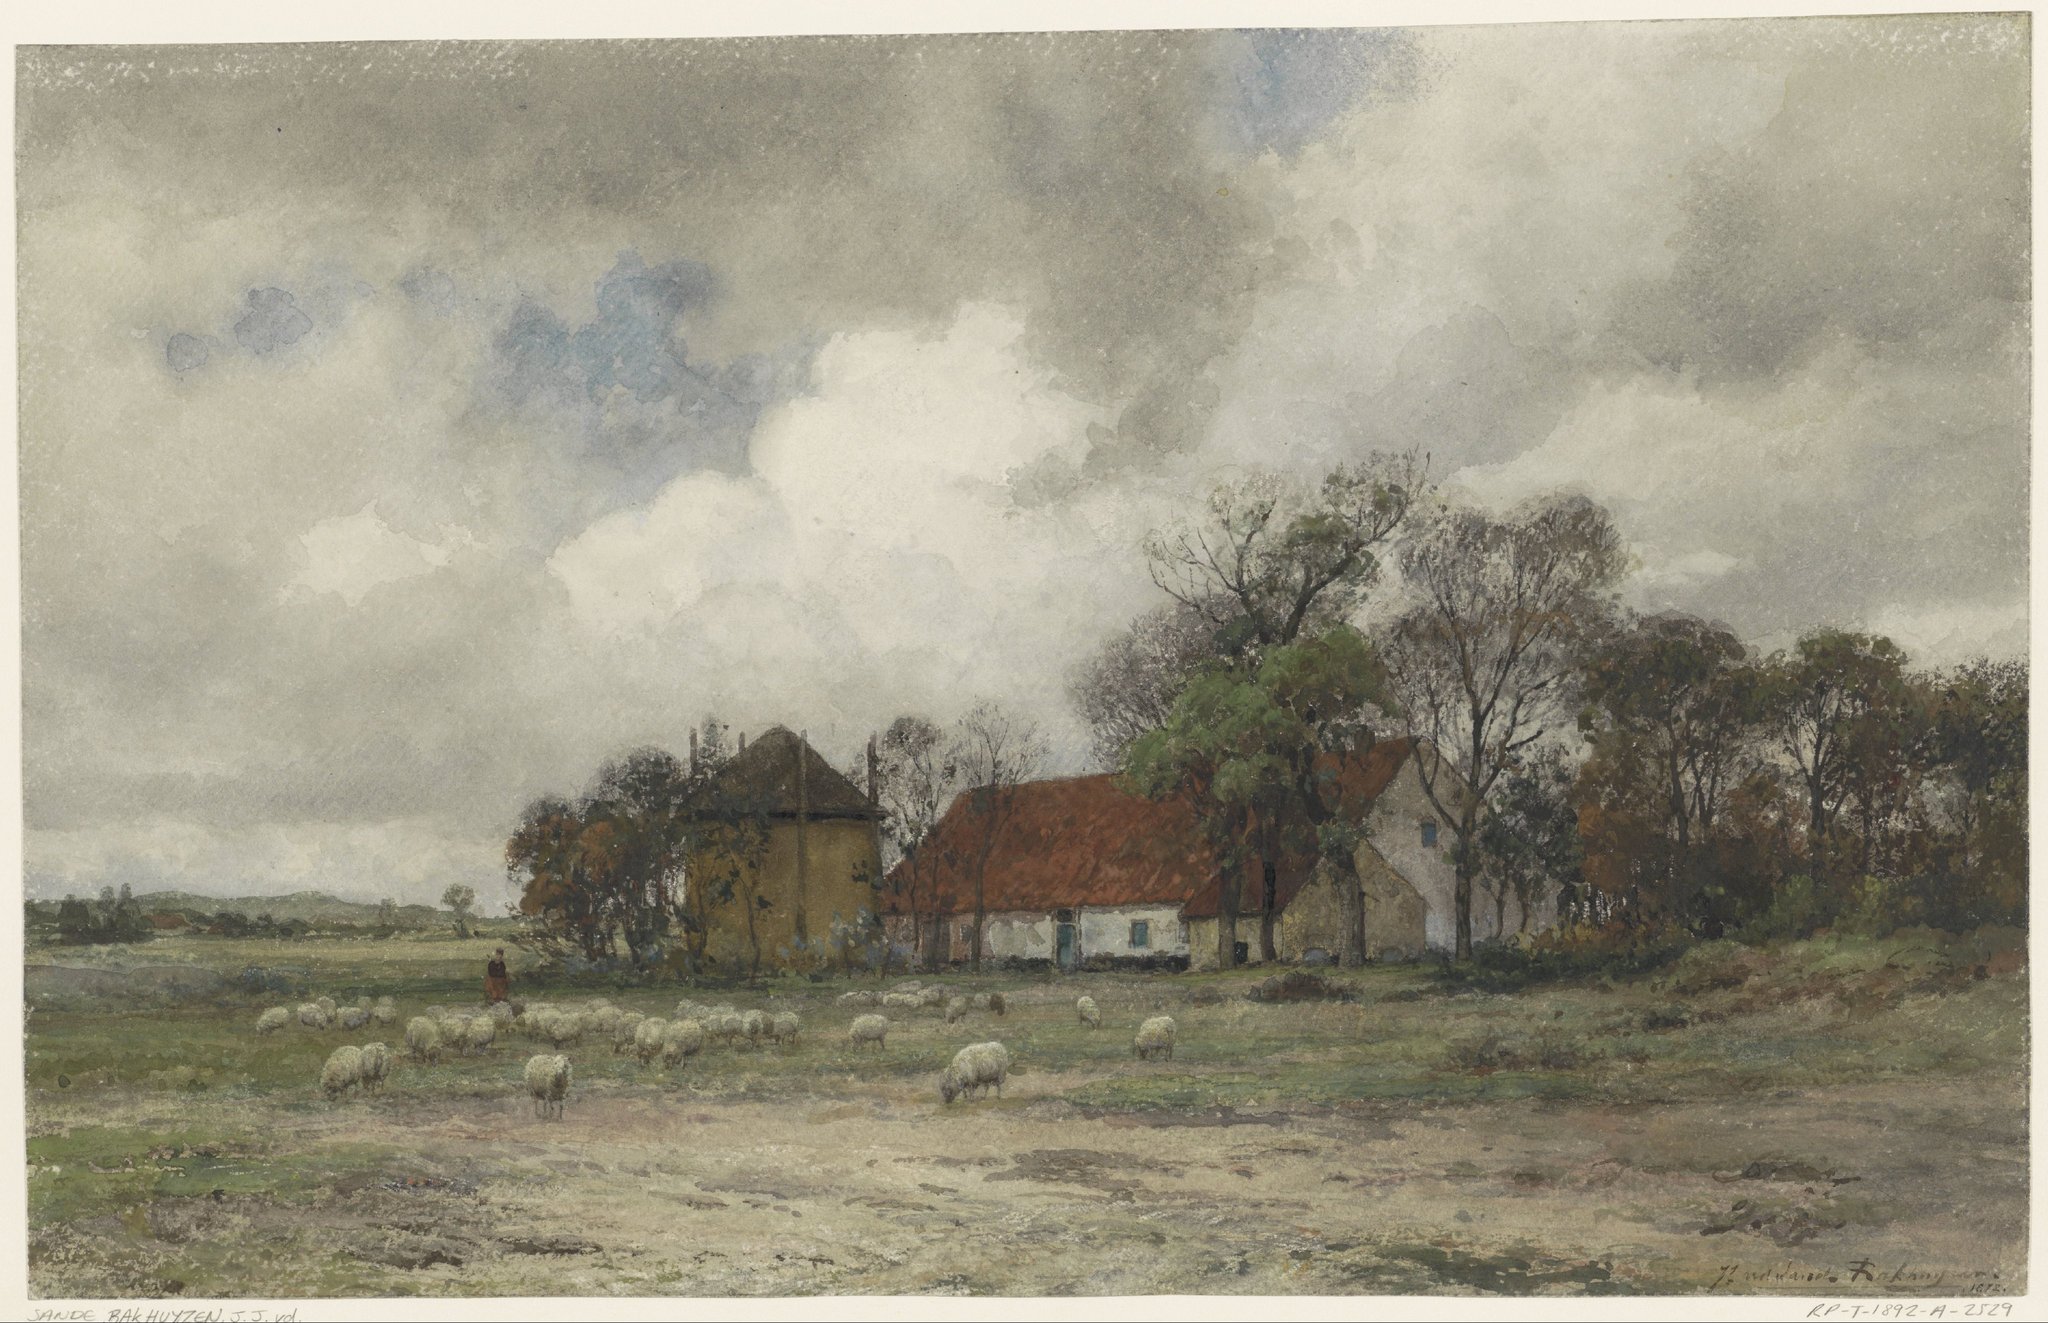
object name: watercolor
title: Landschap met boerderij en herder met schapen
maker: julius jacobus van de sande bakhuyzen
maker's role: draughtsman, painter, print maker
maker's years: 1835-1925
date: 1872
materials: paper, watercolor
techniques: brush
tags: farm or solitary house in landscape